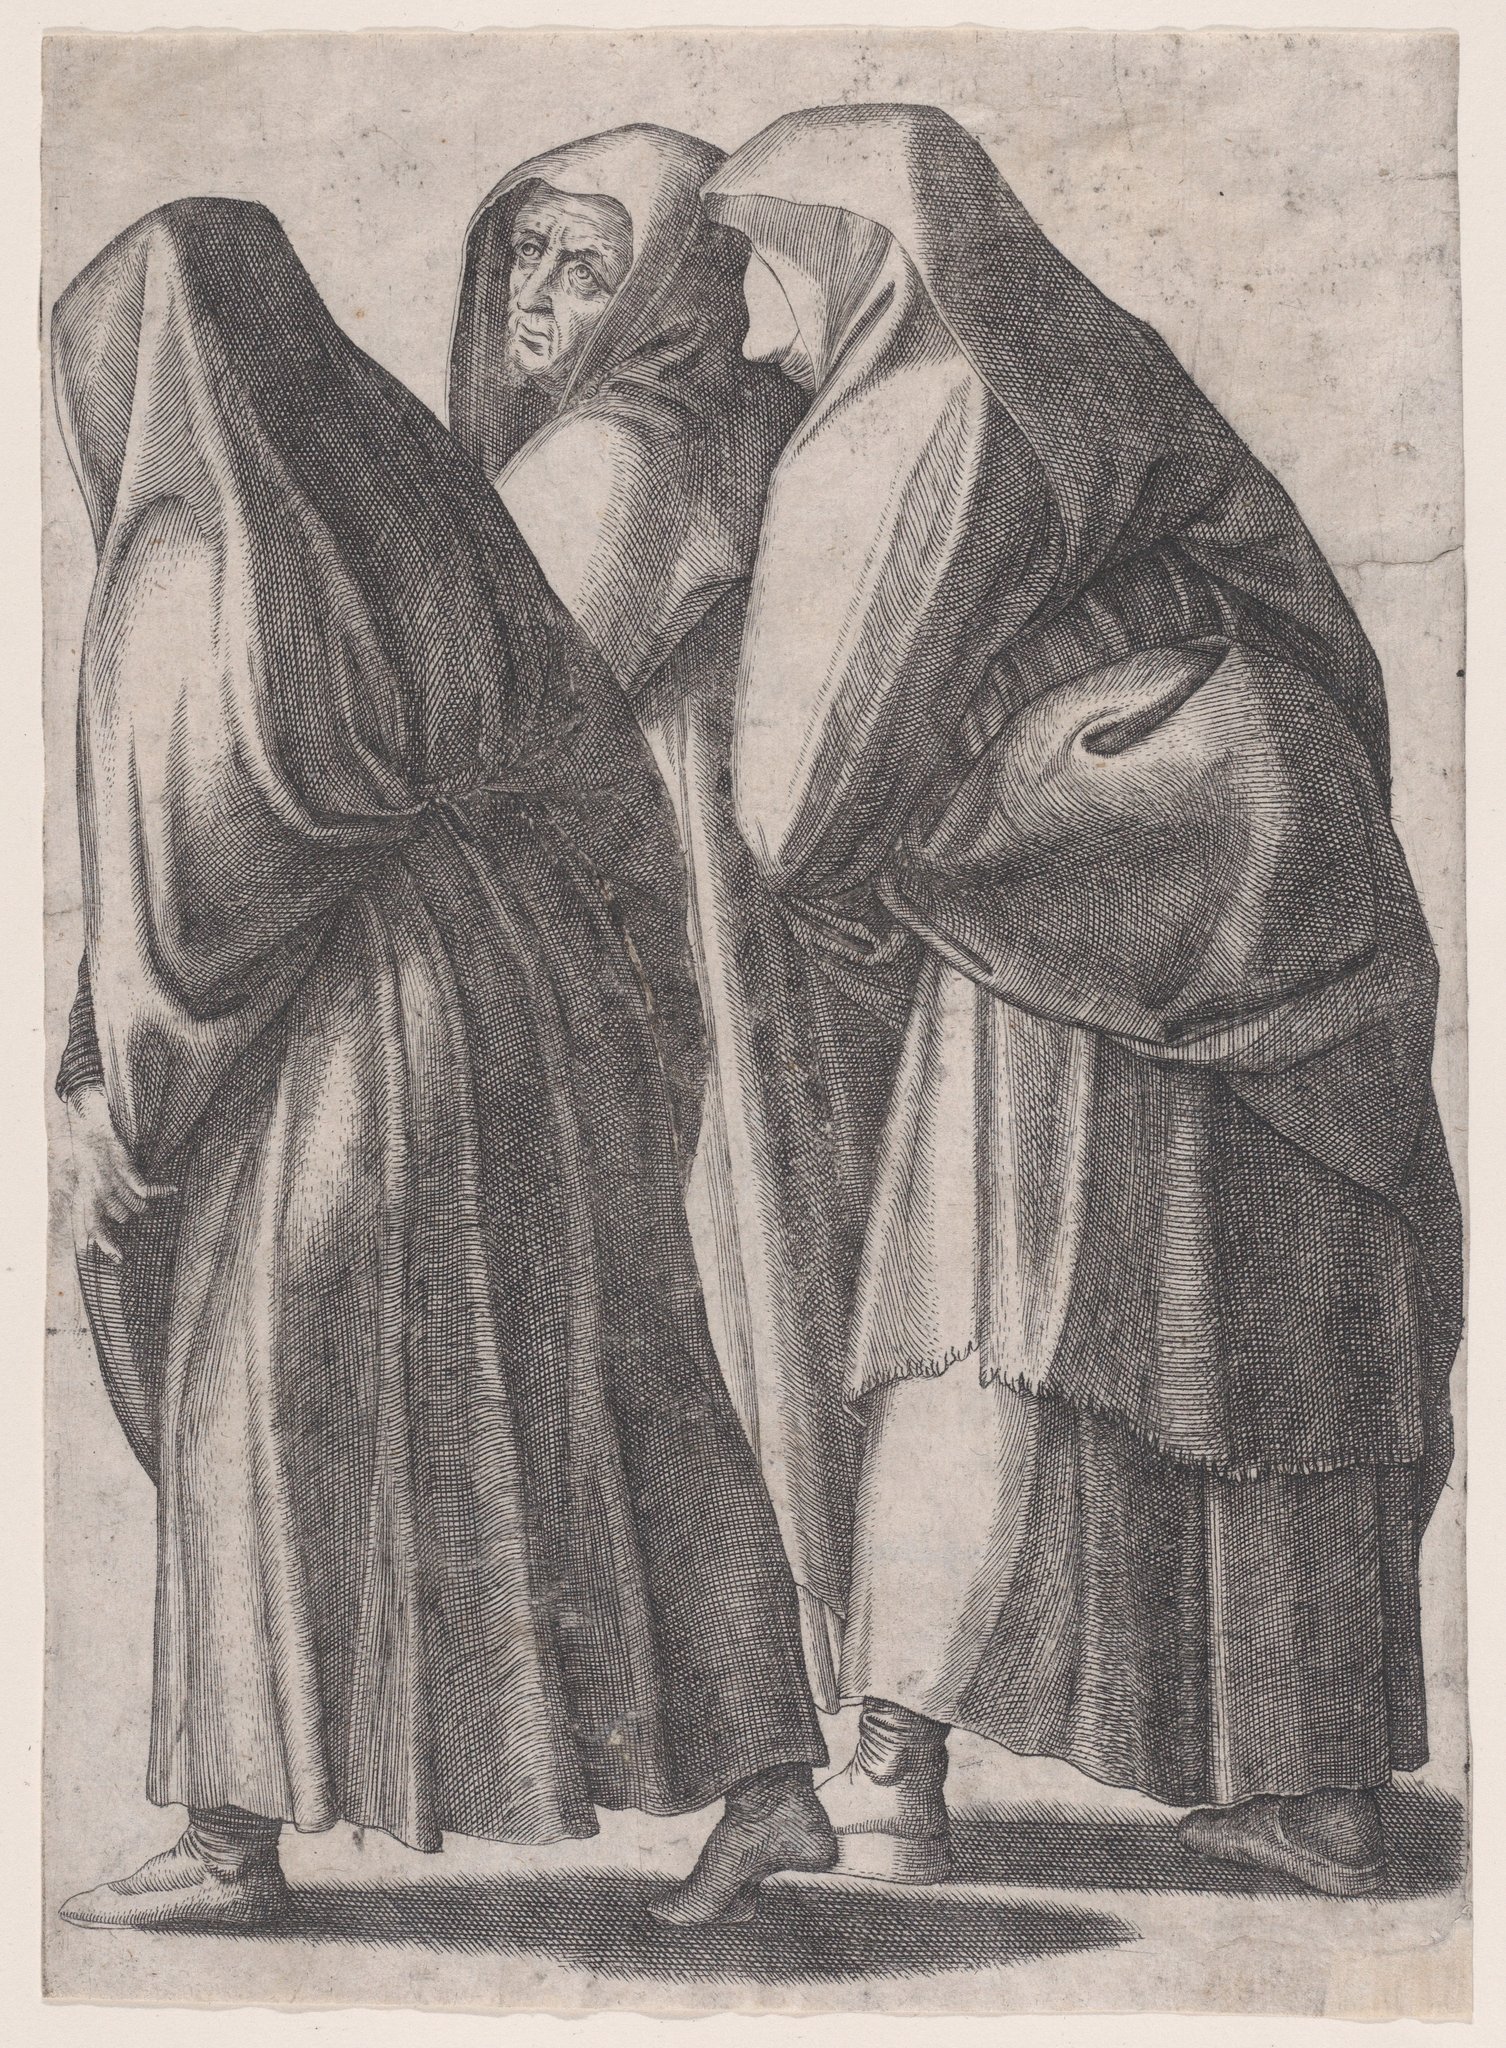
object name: print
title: The Three Holy Women Going to the Sepulchre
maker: agostino veneziano (agostino dei musi)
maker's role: artist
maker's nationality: italian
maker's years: 1490-1536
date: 1514-1536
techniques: engraving